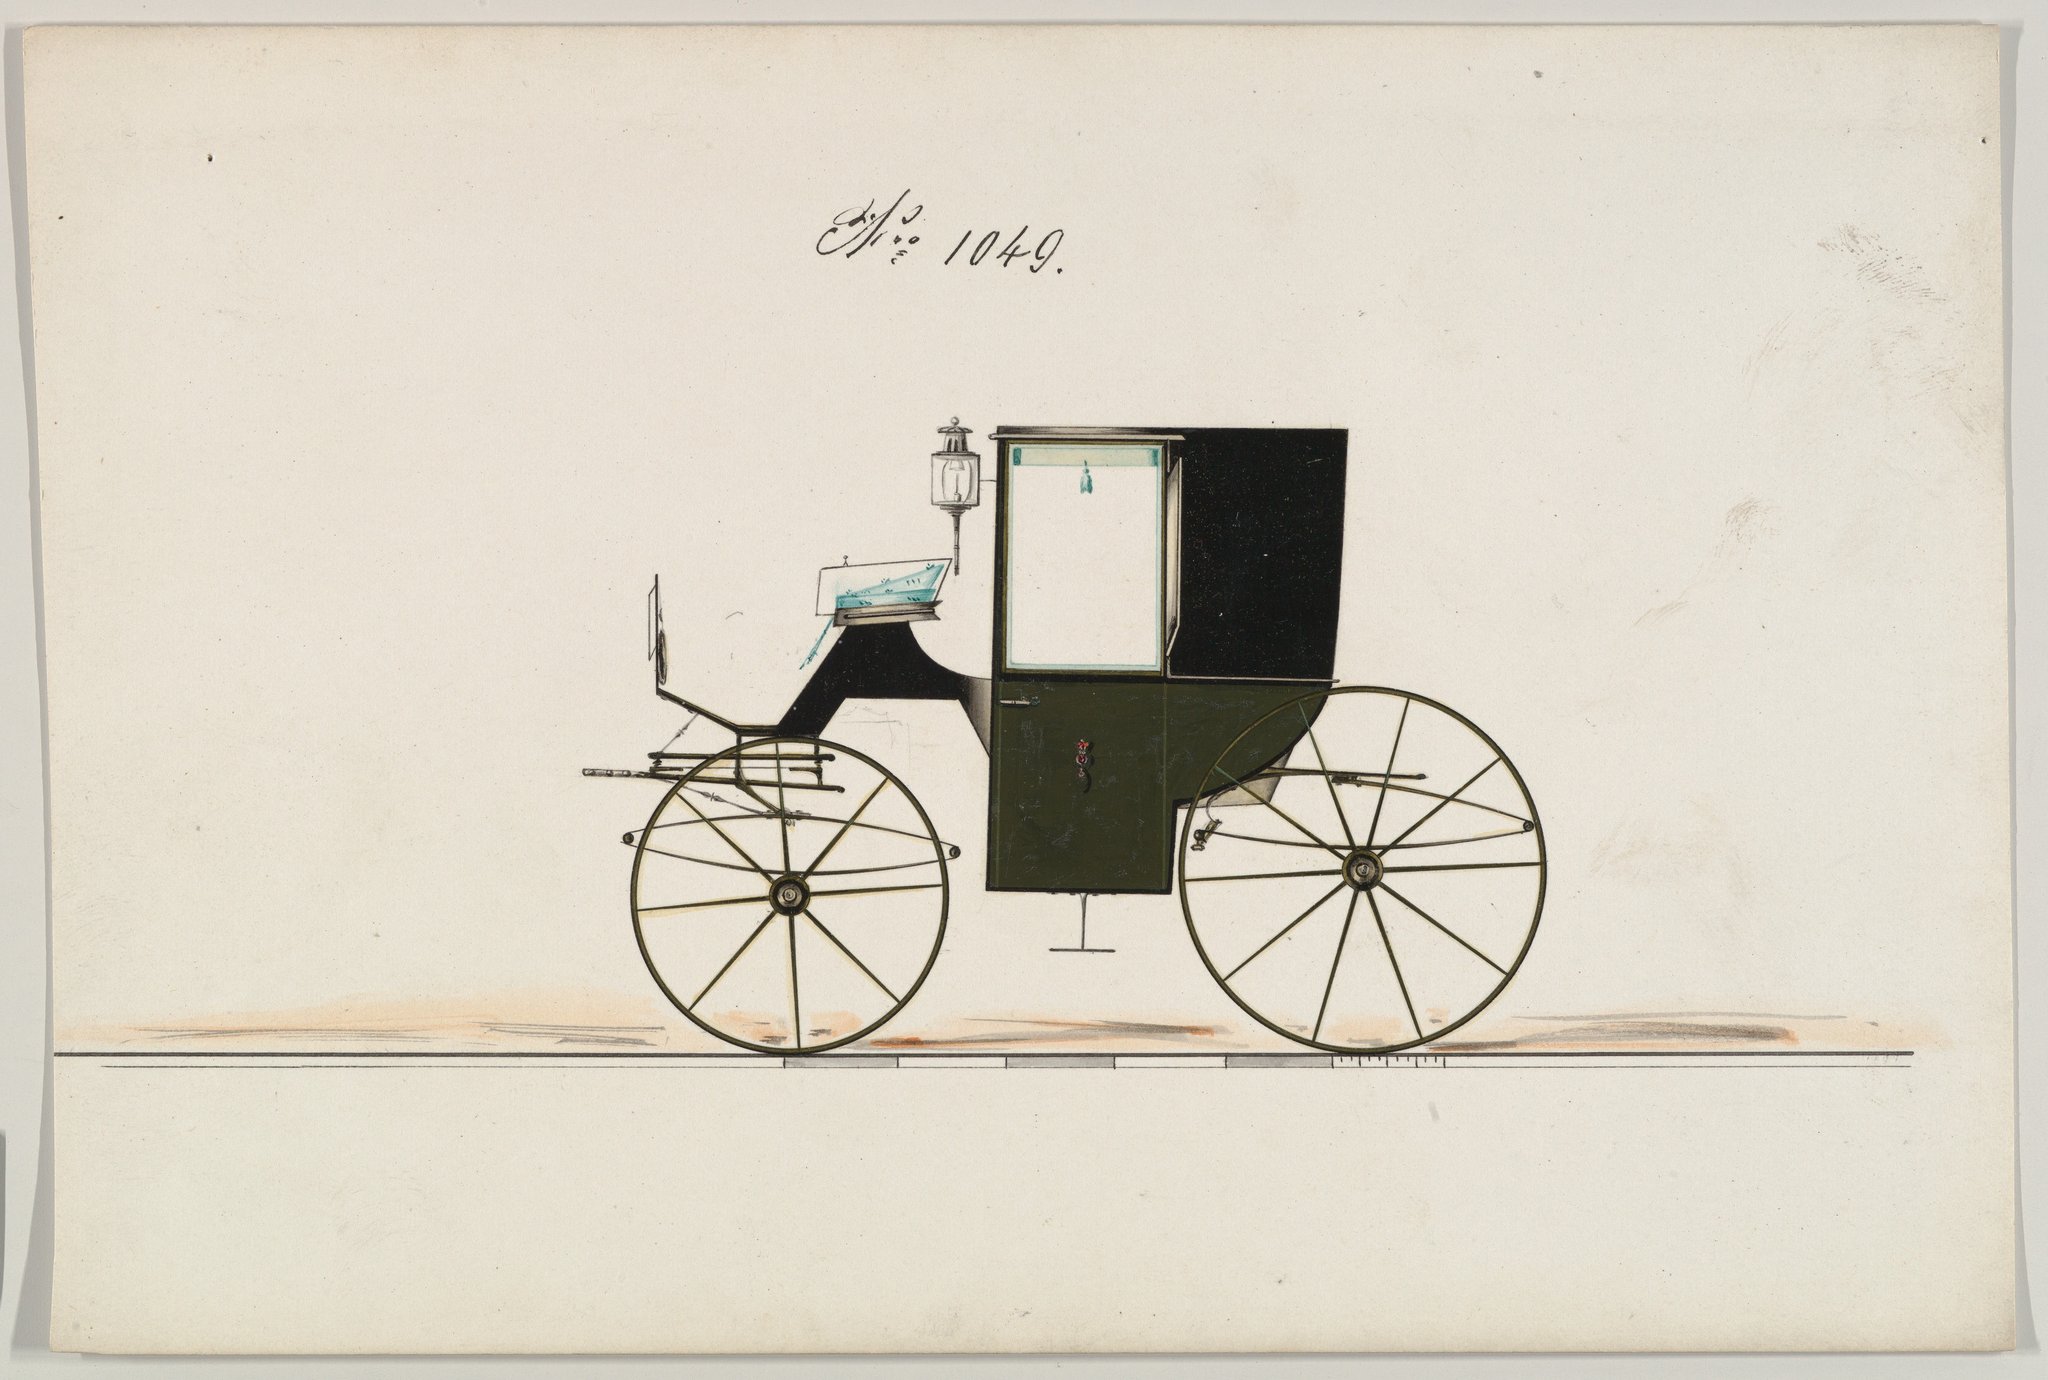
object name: drawing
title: Coupe #1049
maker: brewster & co.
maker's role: manufacturer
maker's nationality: american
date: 1850-1870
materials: gouache, gum arabic, ink, watercolor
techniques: pen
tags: carriages